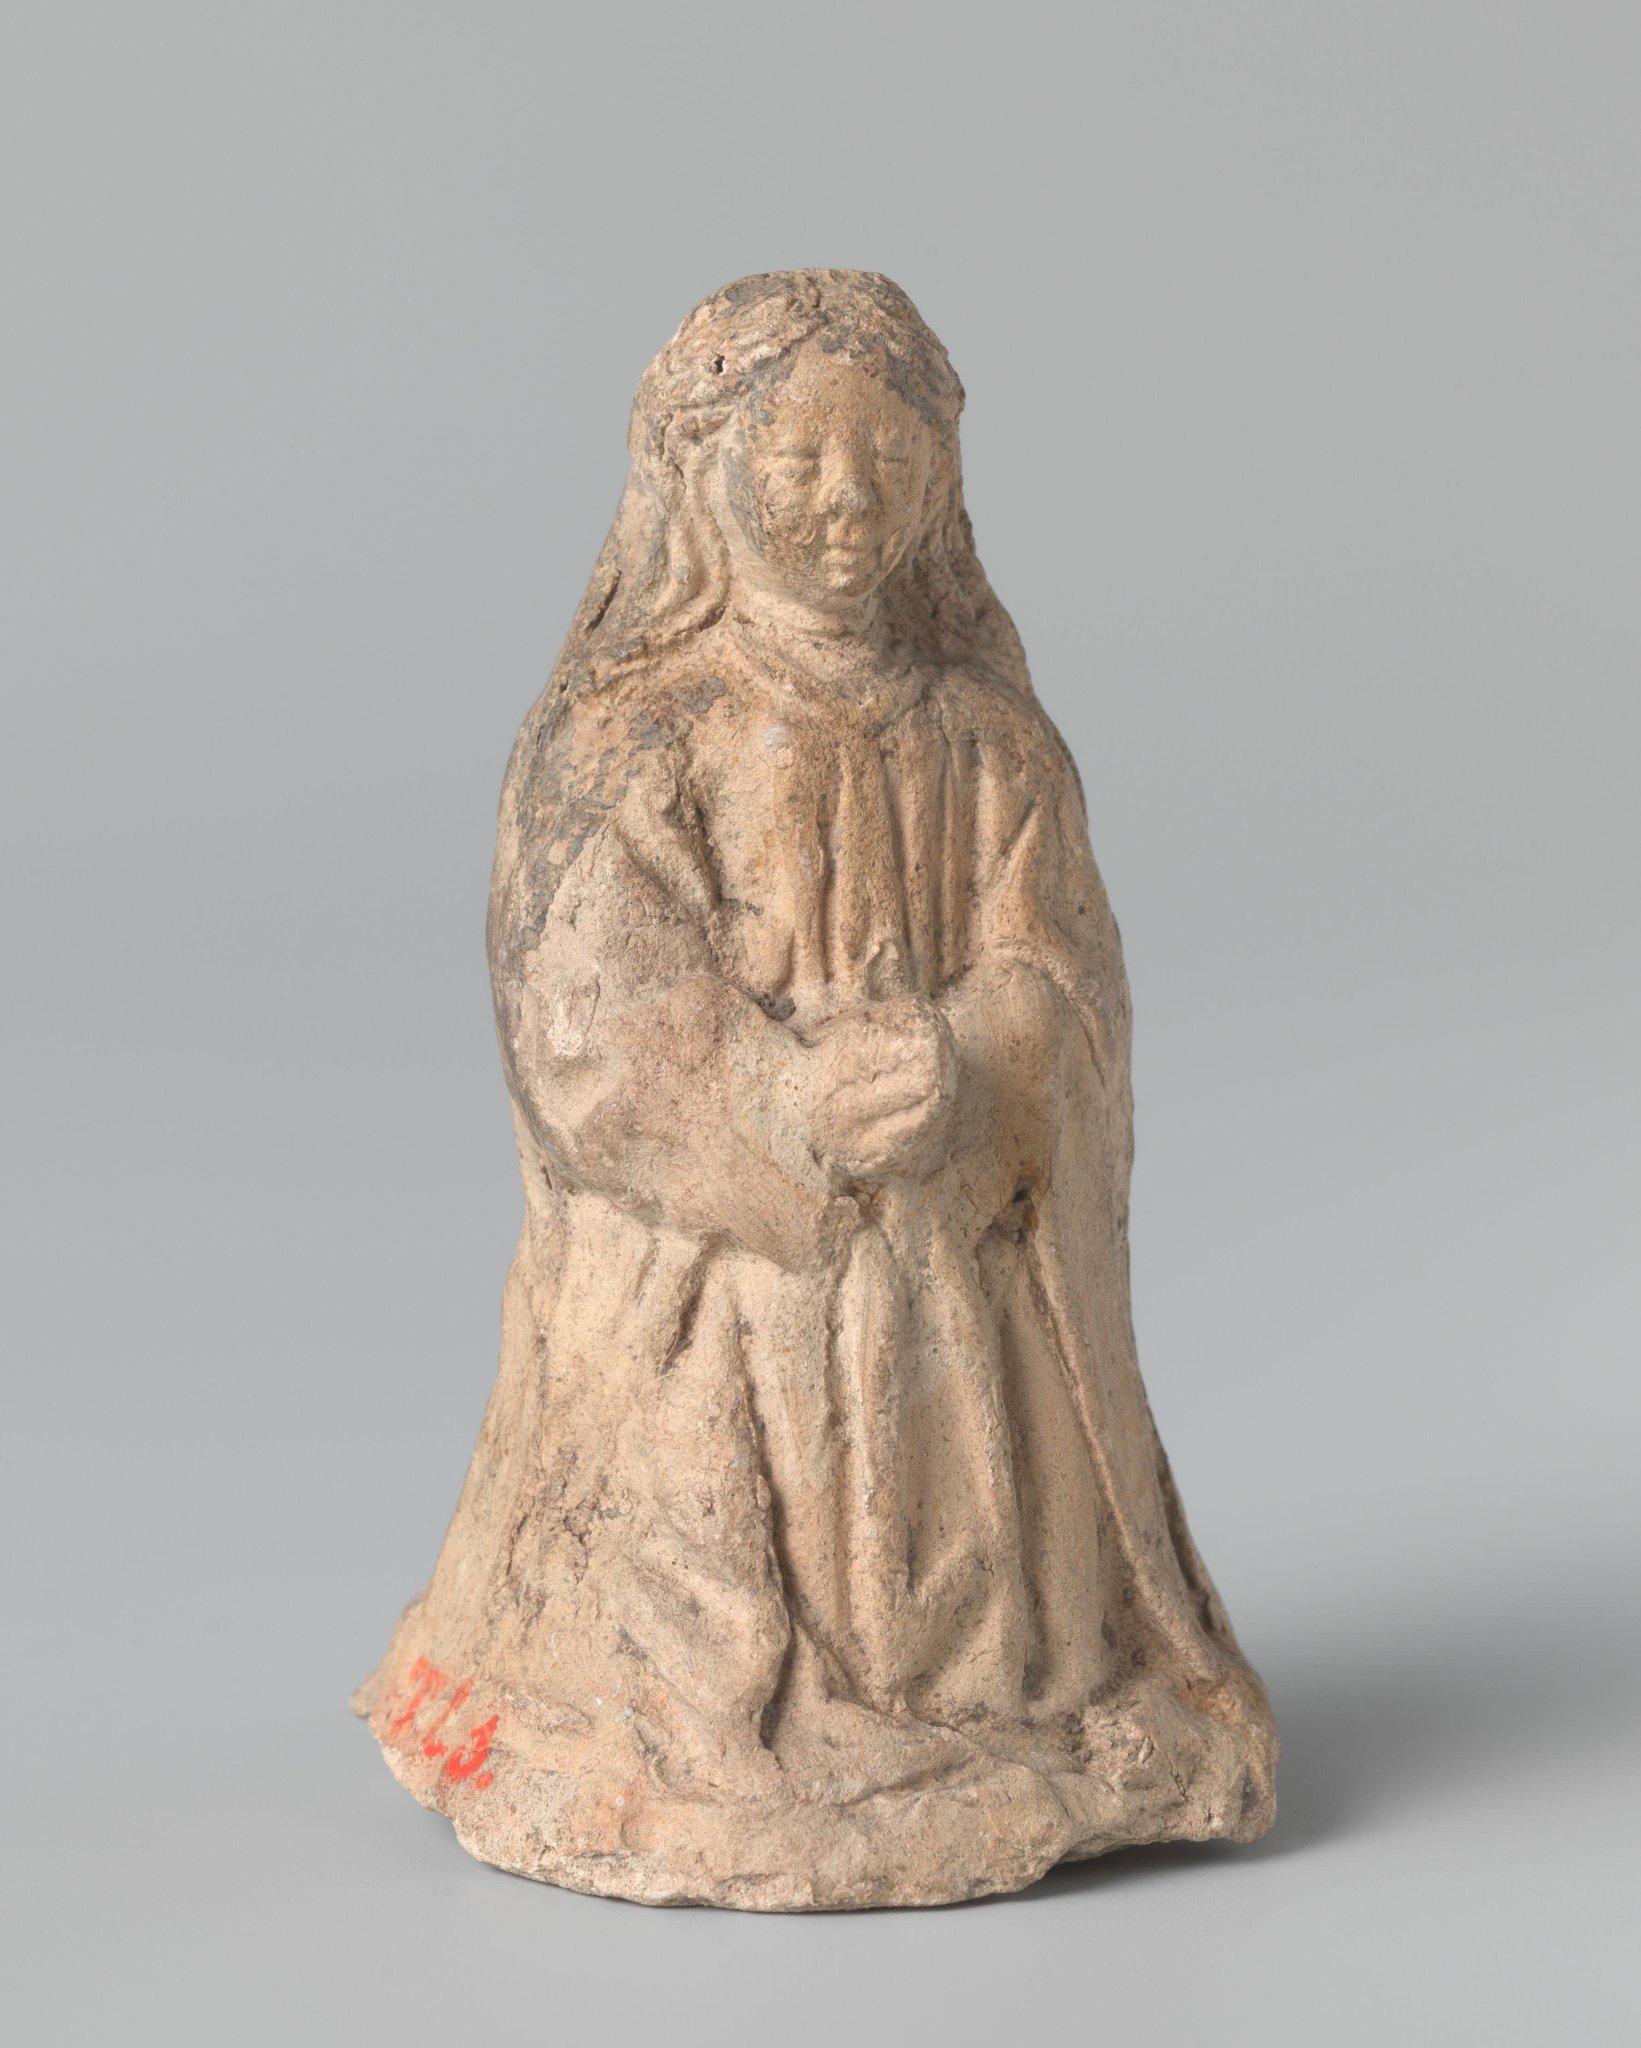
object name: sculpture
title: Kneeling Virgin, from a Nativity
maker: Anonymous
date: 1425-1475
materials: clay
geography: northern netherlands